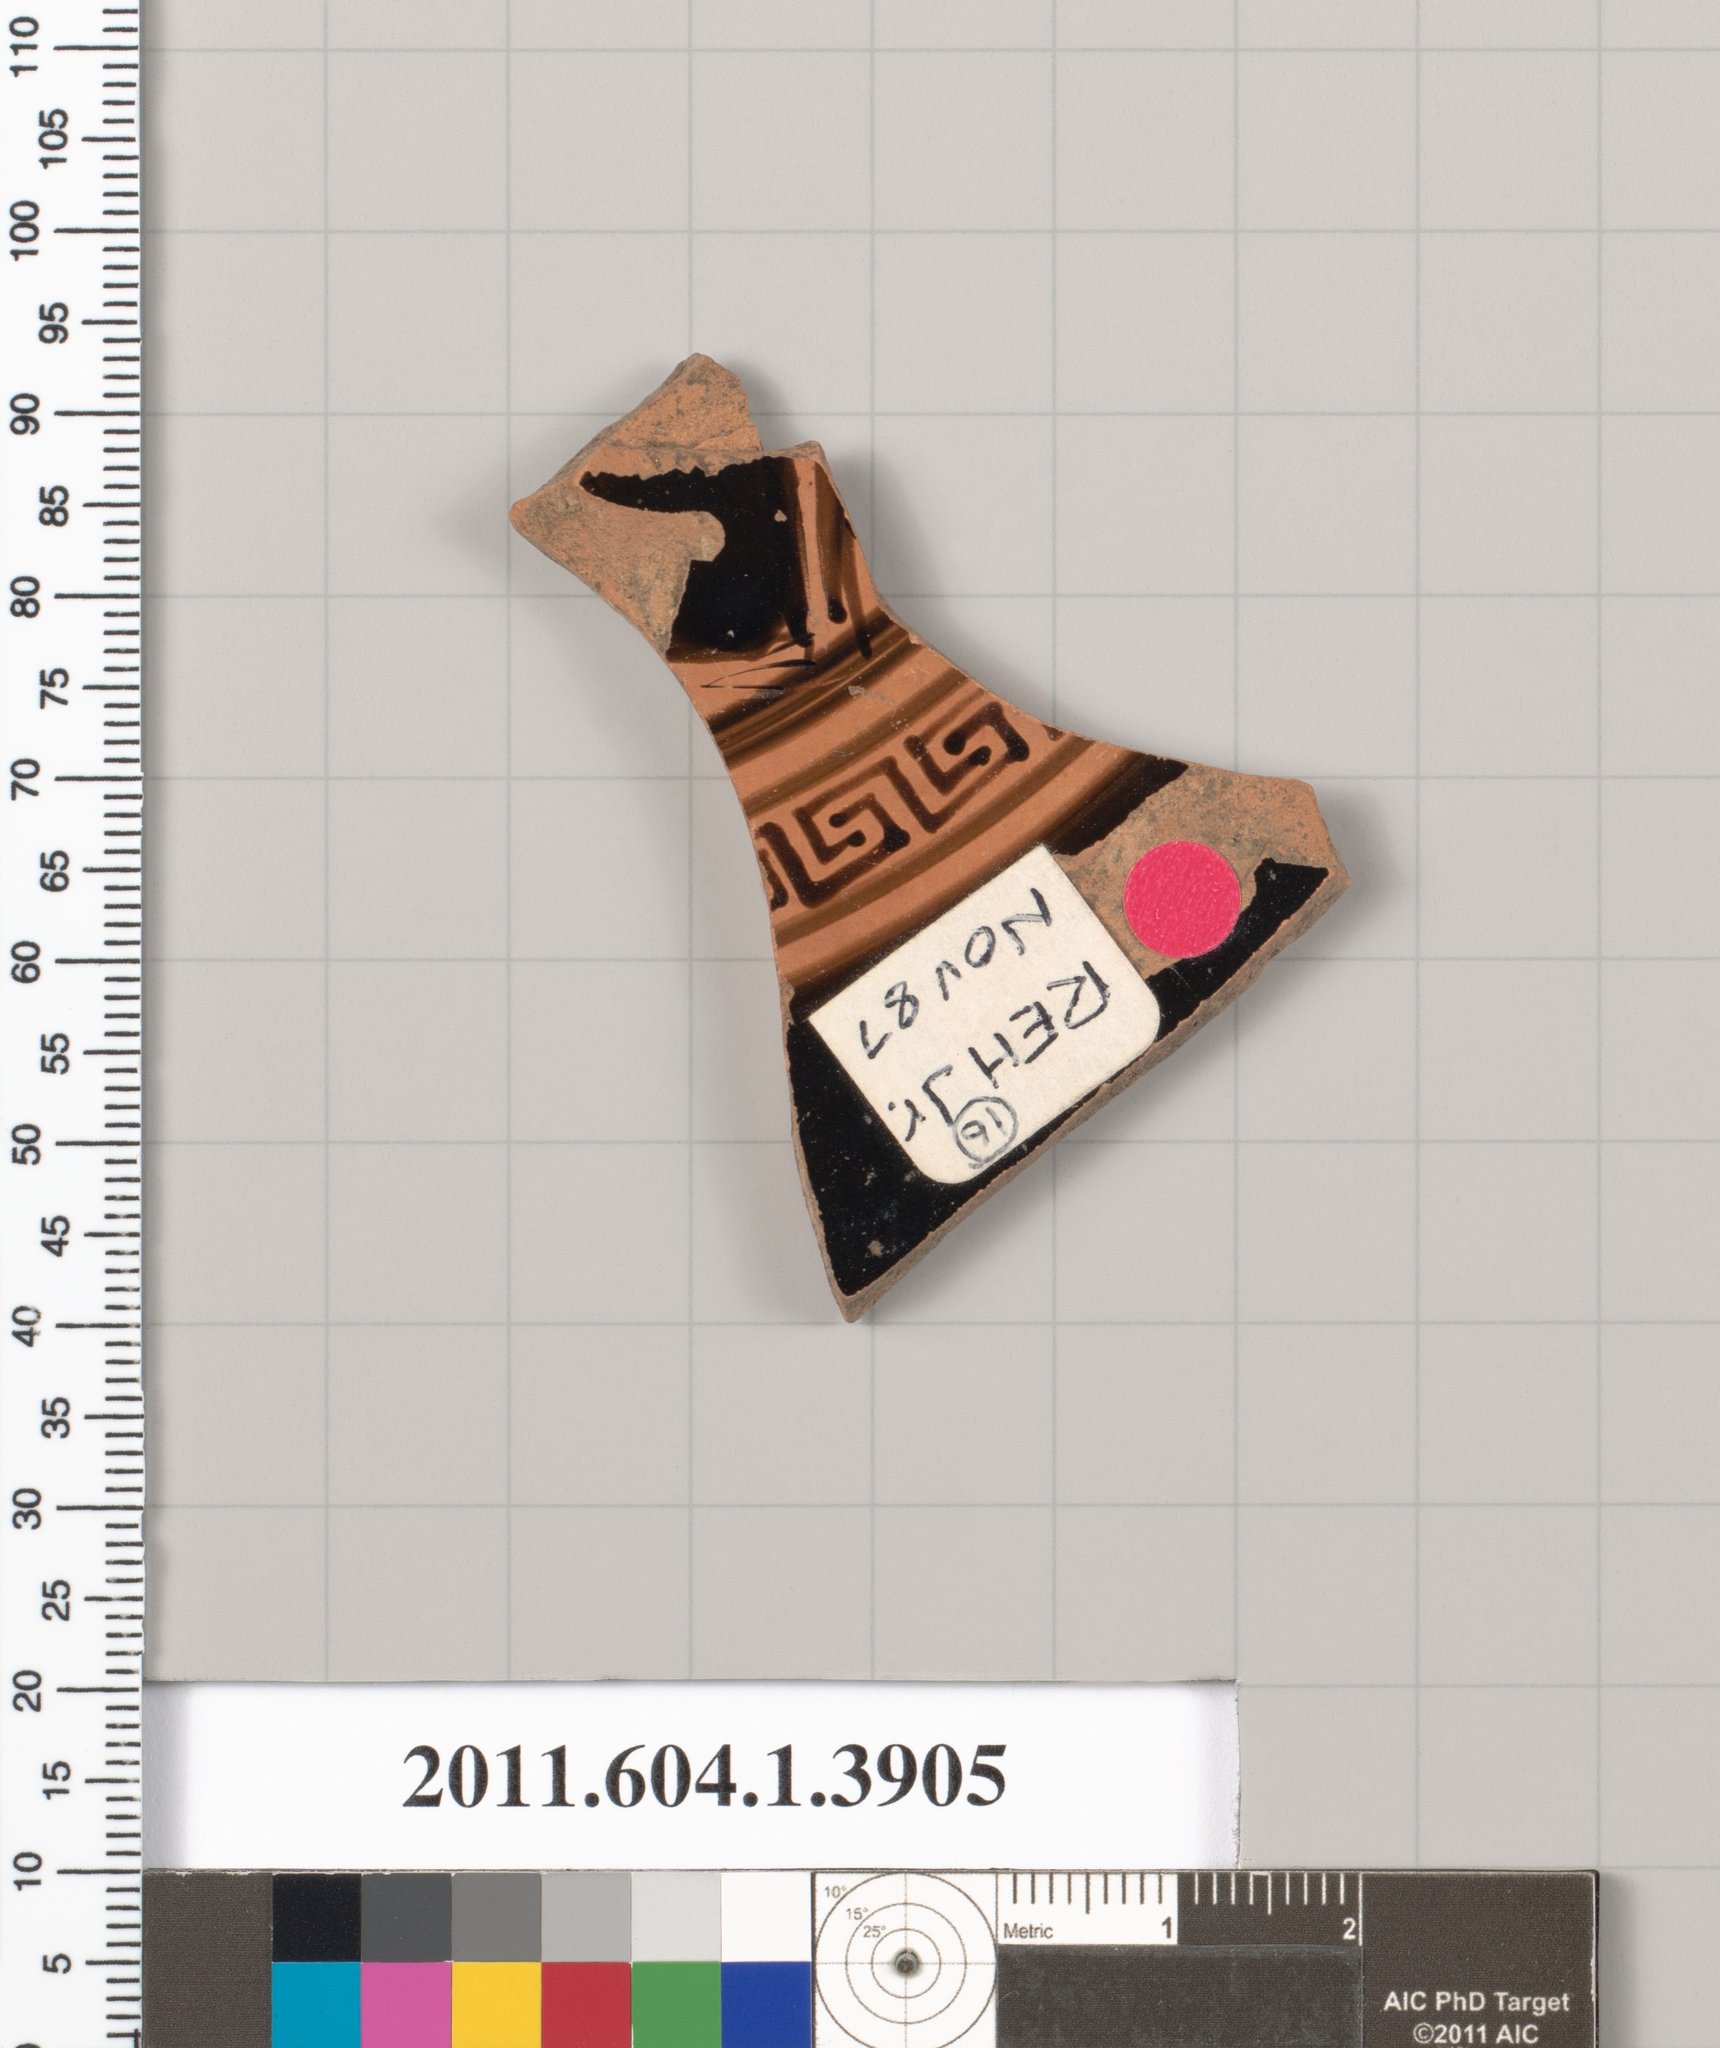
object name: kylix fragment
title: Terracotta fragment of a kylix (drinking cup)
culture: greek, attic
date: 475-451 BCE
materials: terracotta